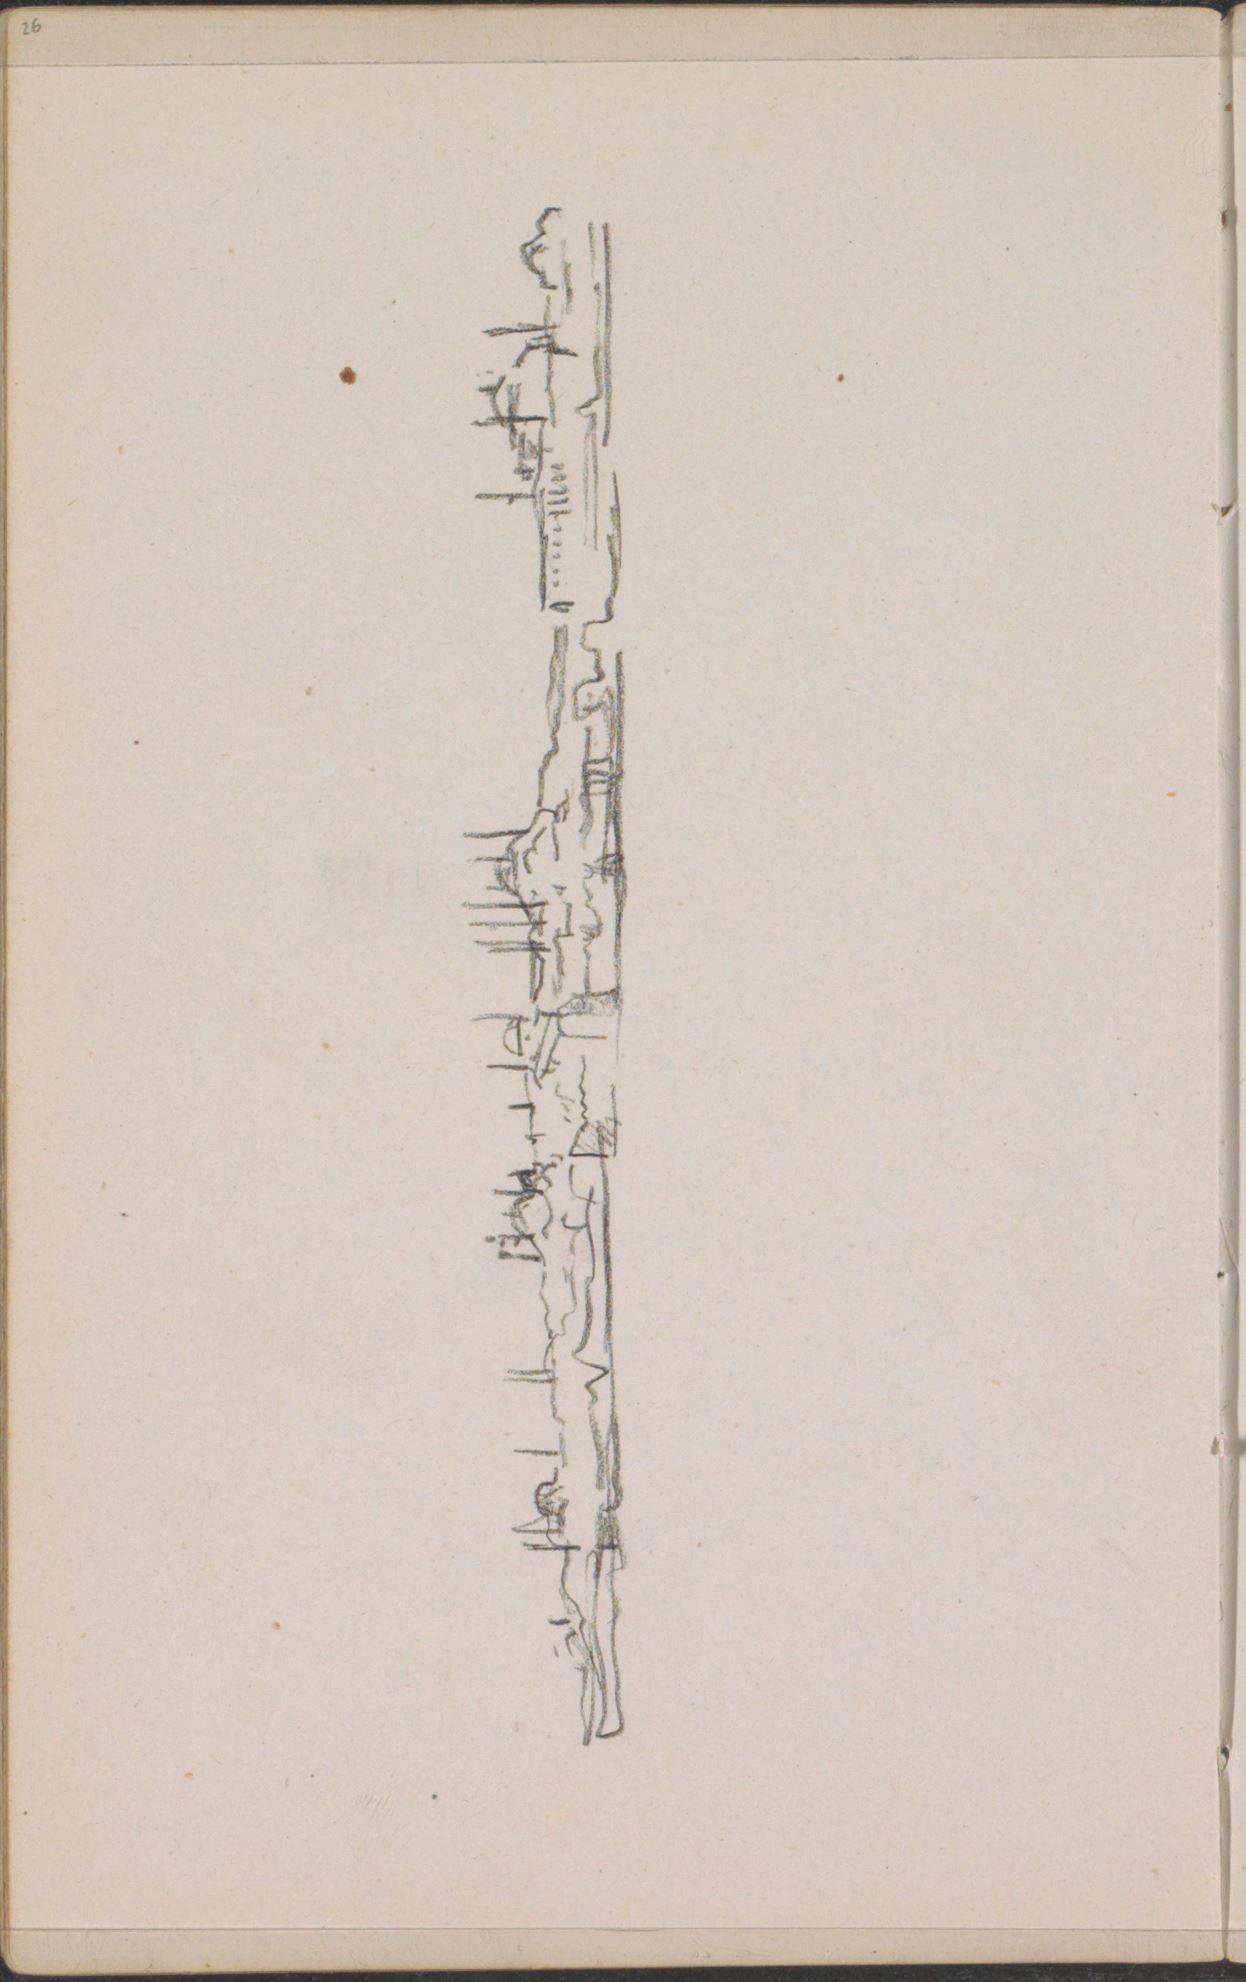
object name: sketchbook leaf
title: Gezicht op een stad, mogelijk Constantinopel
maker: marius bauer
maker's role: draughtsman, print maker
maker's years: 1867-1932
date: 1896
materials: chalk, paper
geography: istanbul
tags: city-view, and landscape with man-made constructions, temple, shrine ~ islam, mohammedanism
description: Het gezicht op de stad toont de minaretten en koepels van verschillende moskeeën. Pagina 26 uit een schetsboek met 53 bladen.